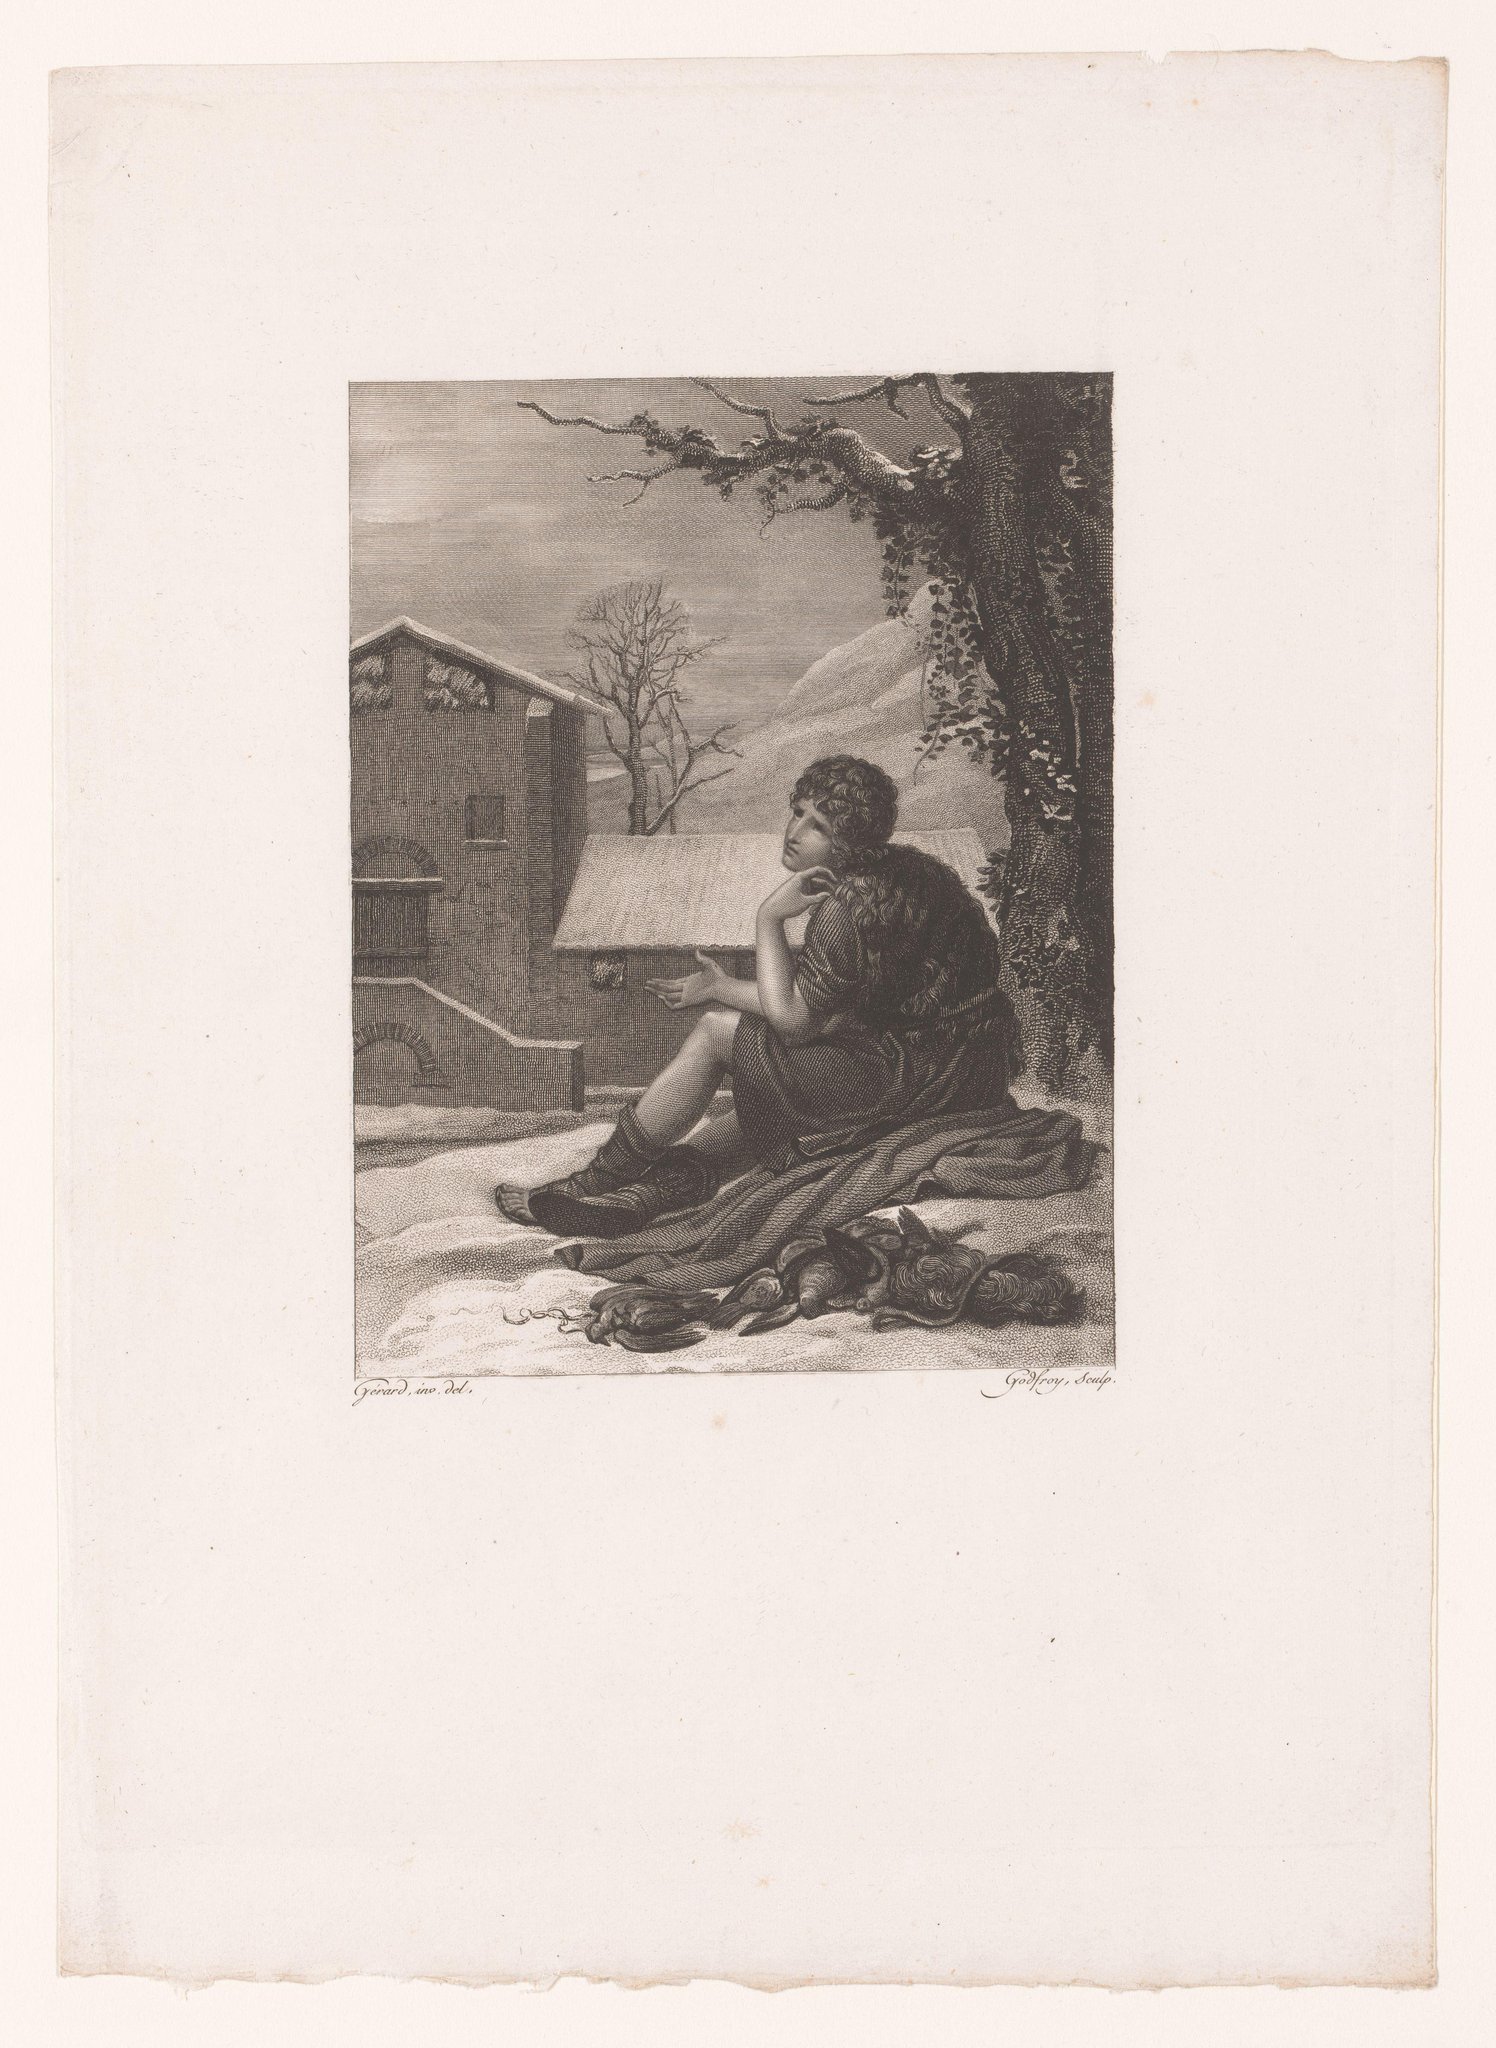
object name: print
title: Daphnis tijdens de vogeljacht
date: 1800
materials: paper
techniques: engraving, etching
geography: paris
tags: bird hunting, daphnis (in greek mythology a shepherd who invented pastoral poetry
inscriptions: collector's mark: Lugt 2228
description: Prent uit: Amyot, Jacques. Les Amours pastorales de Daphnis et de Chloé (...). Parijs: François-Ambroise Didot, 1800.